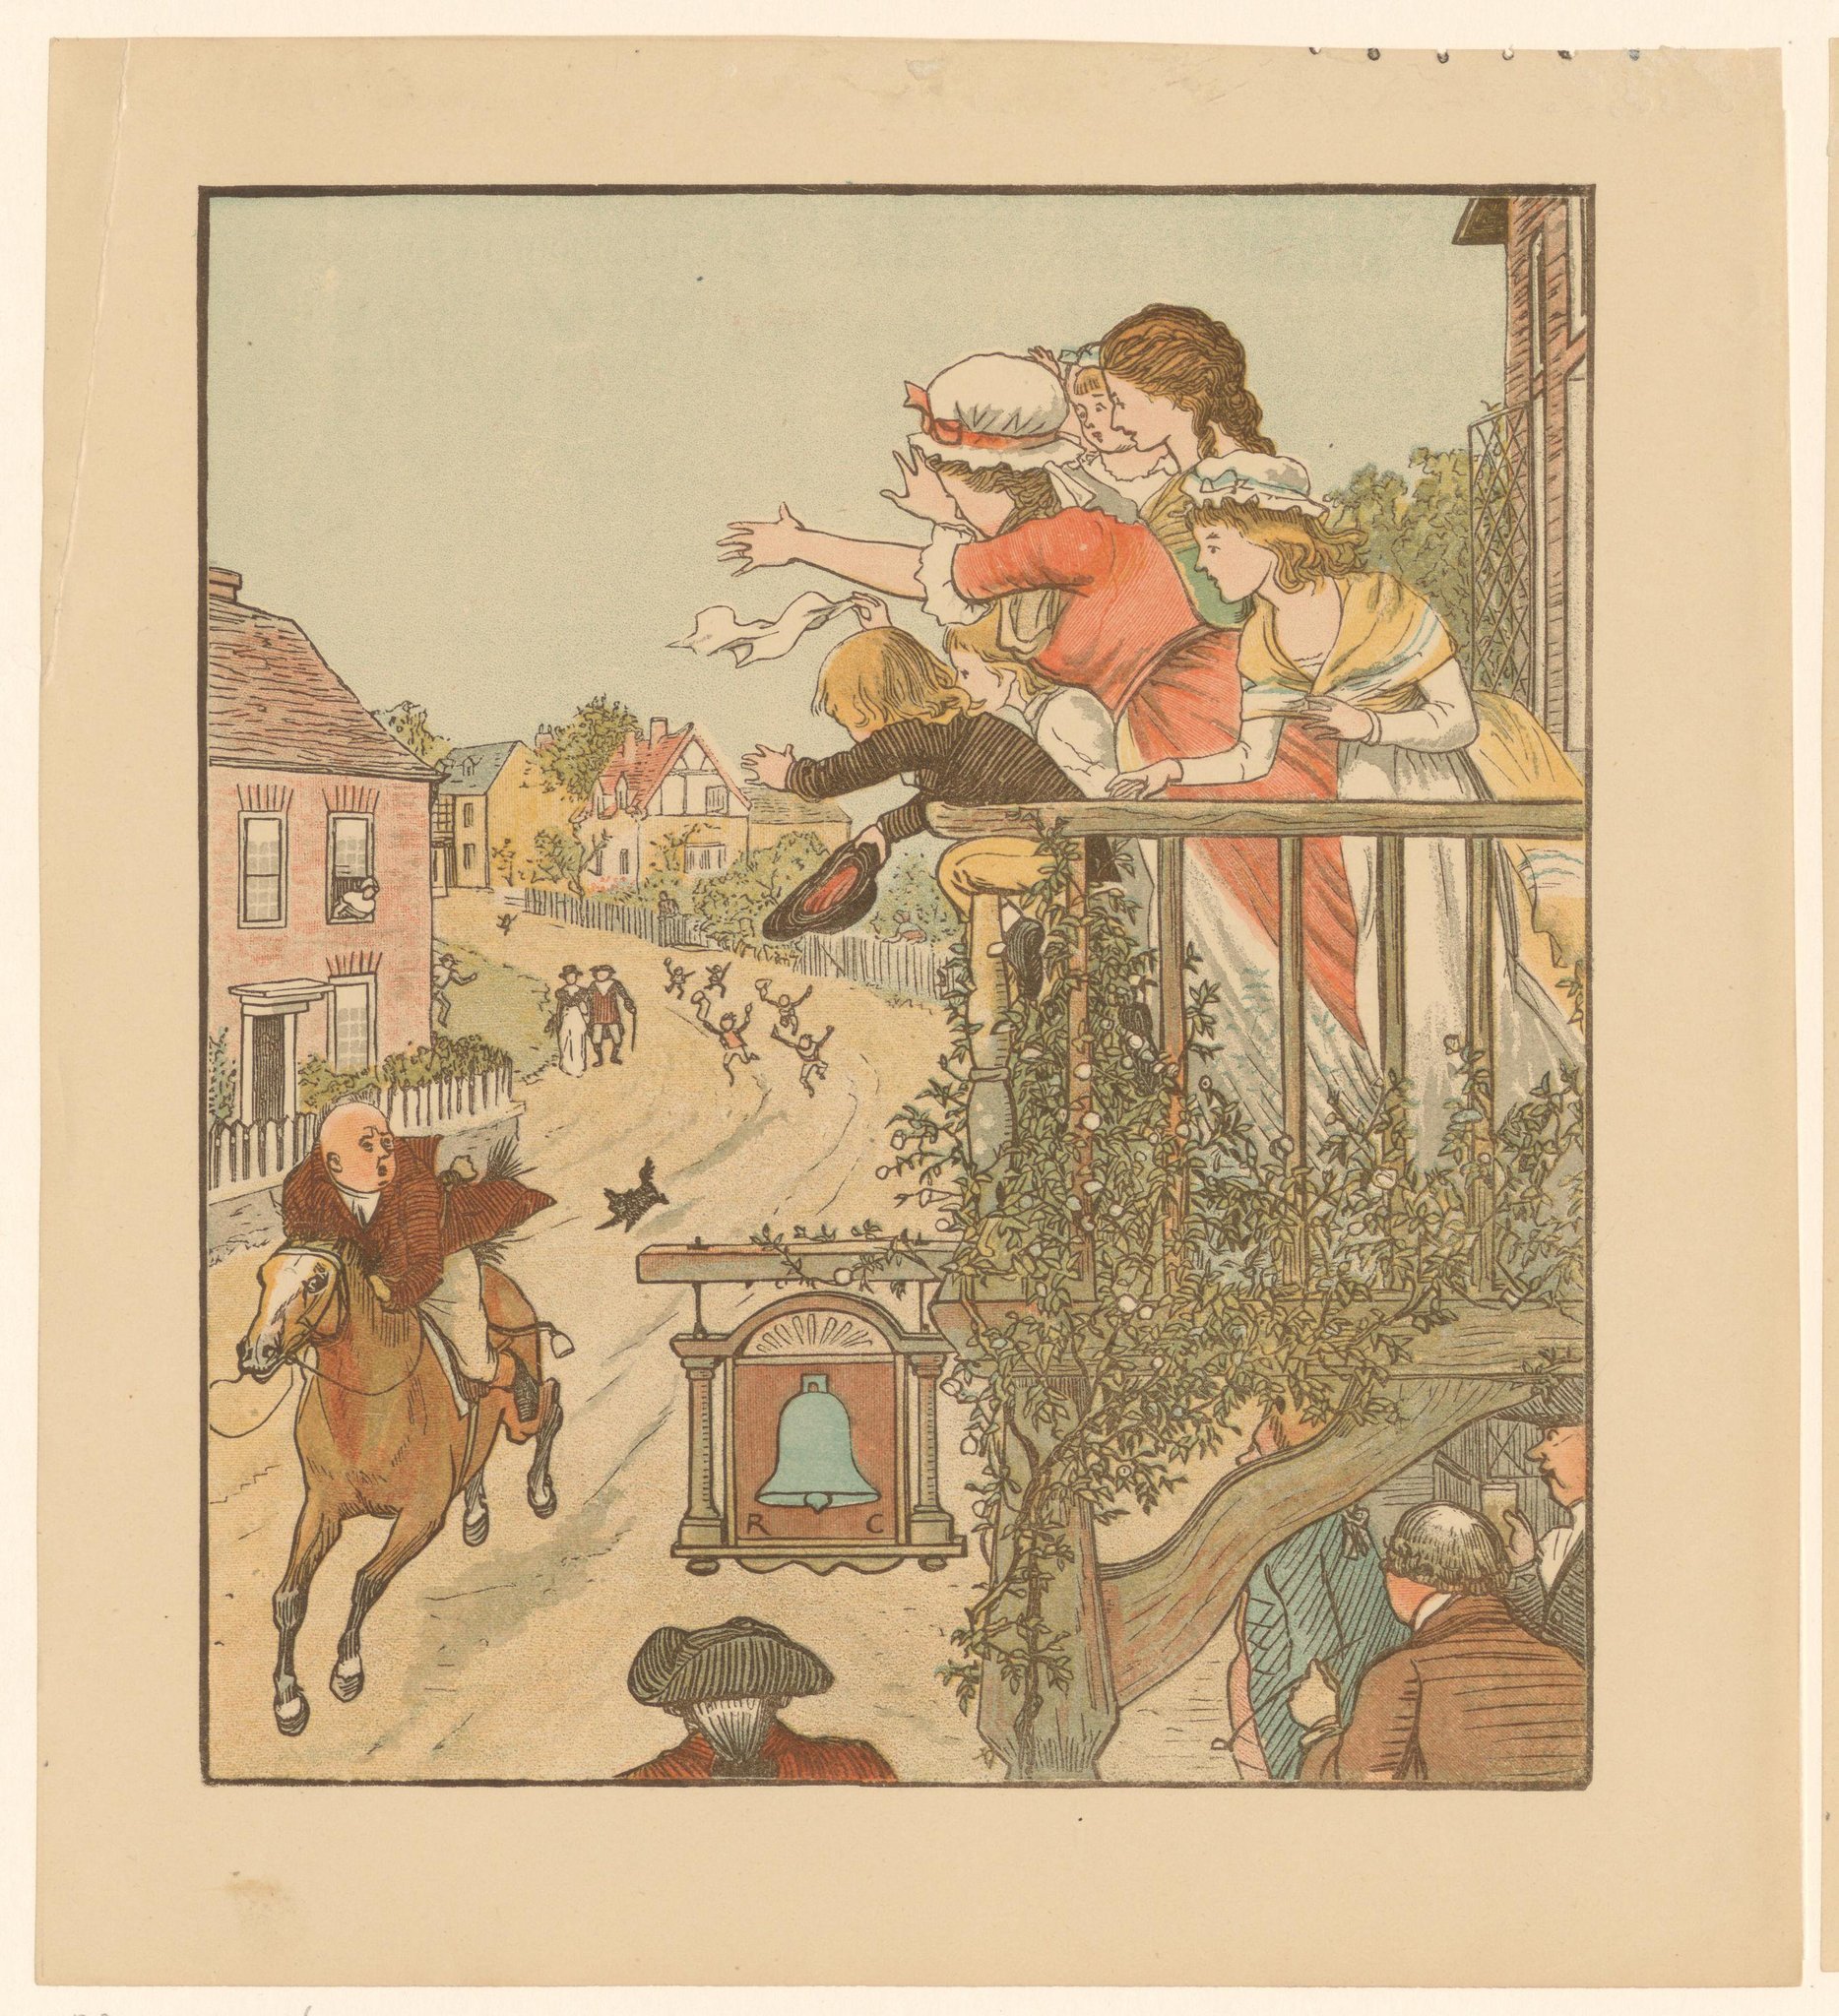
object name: print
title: Vrouwen en kinderen zwaaien vanaf een balkon naar een ruiter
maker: randolph caldecott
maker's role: painter, print maker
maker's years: 1846-1886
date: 1878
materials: paper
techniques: woodcut, letterpress printing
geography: london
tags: riding a horse, ass, or mule; rider, horseman, handkerchief, balcony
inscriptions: collector's mark: Lugt 2228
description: Prent uit: Cowper, William. The Diverting History of John Gilpin (...). Londen: George Routledge & Sons, 1878.